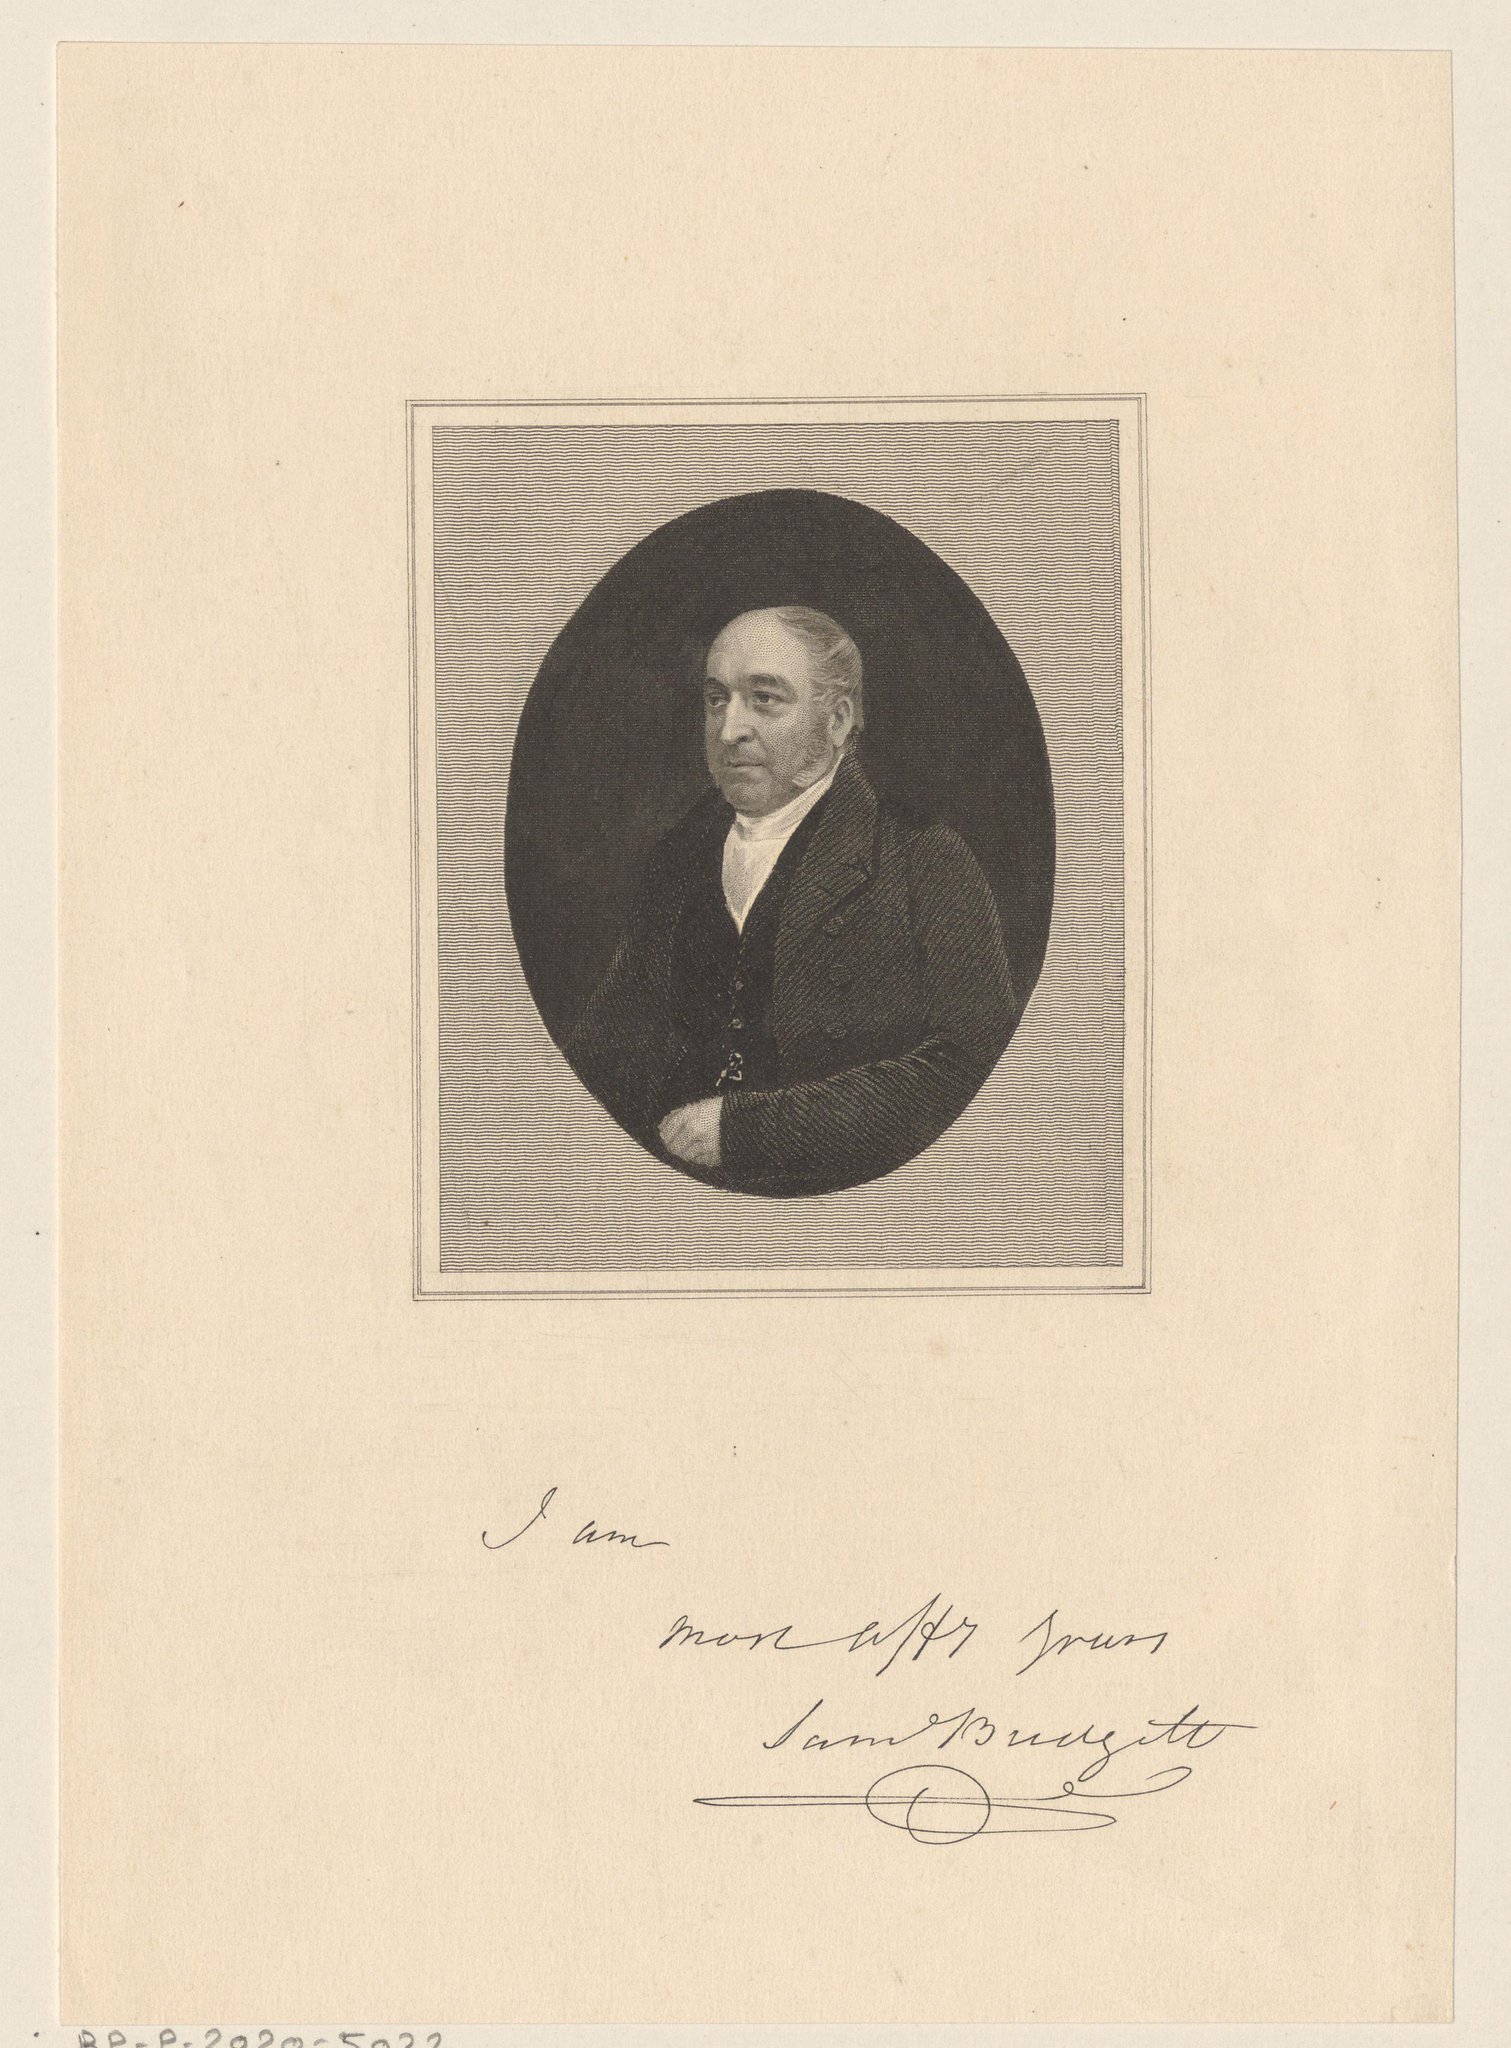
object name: print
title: Portret van Samuel Budgett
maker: Anonymous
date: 1850-1899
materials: paper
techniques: engraving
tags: historical persons, merchant, salesman